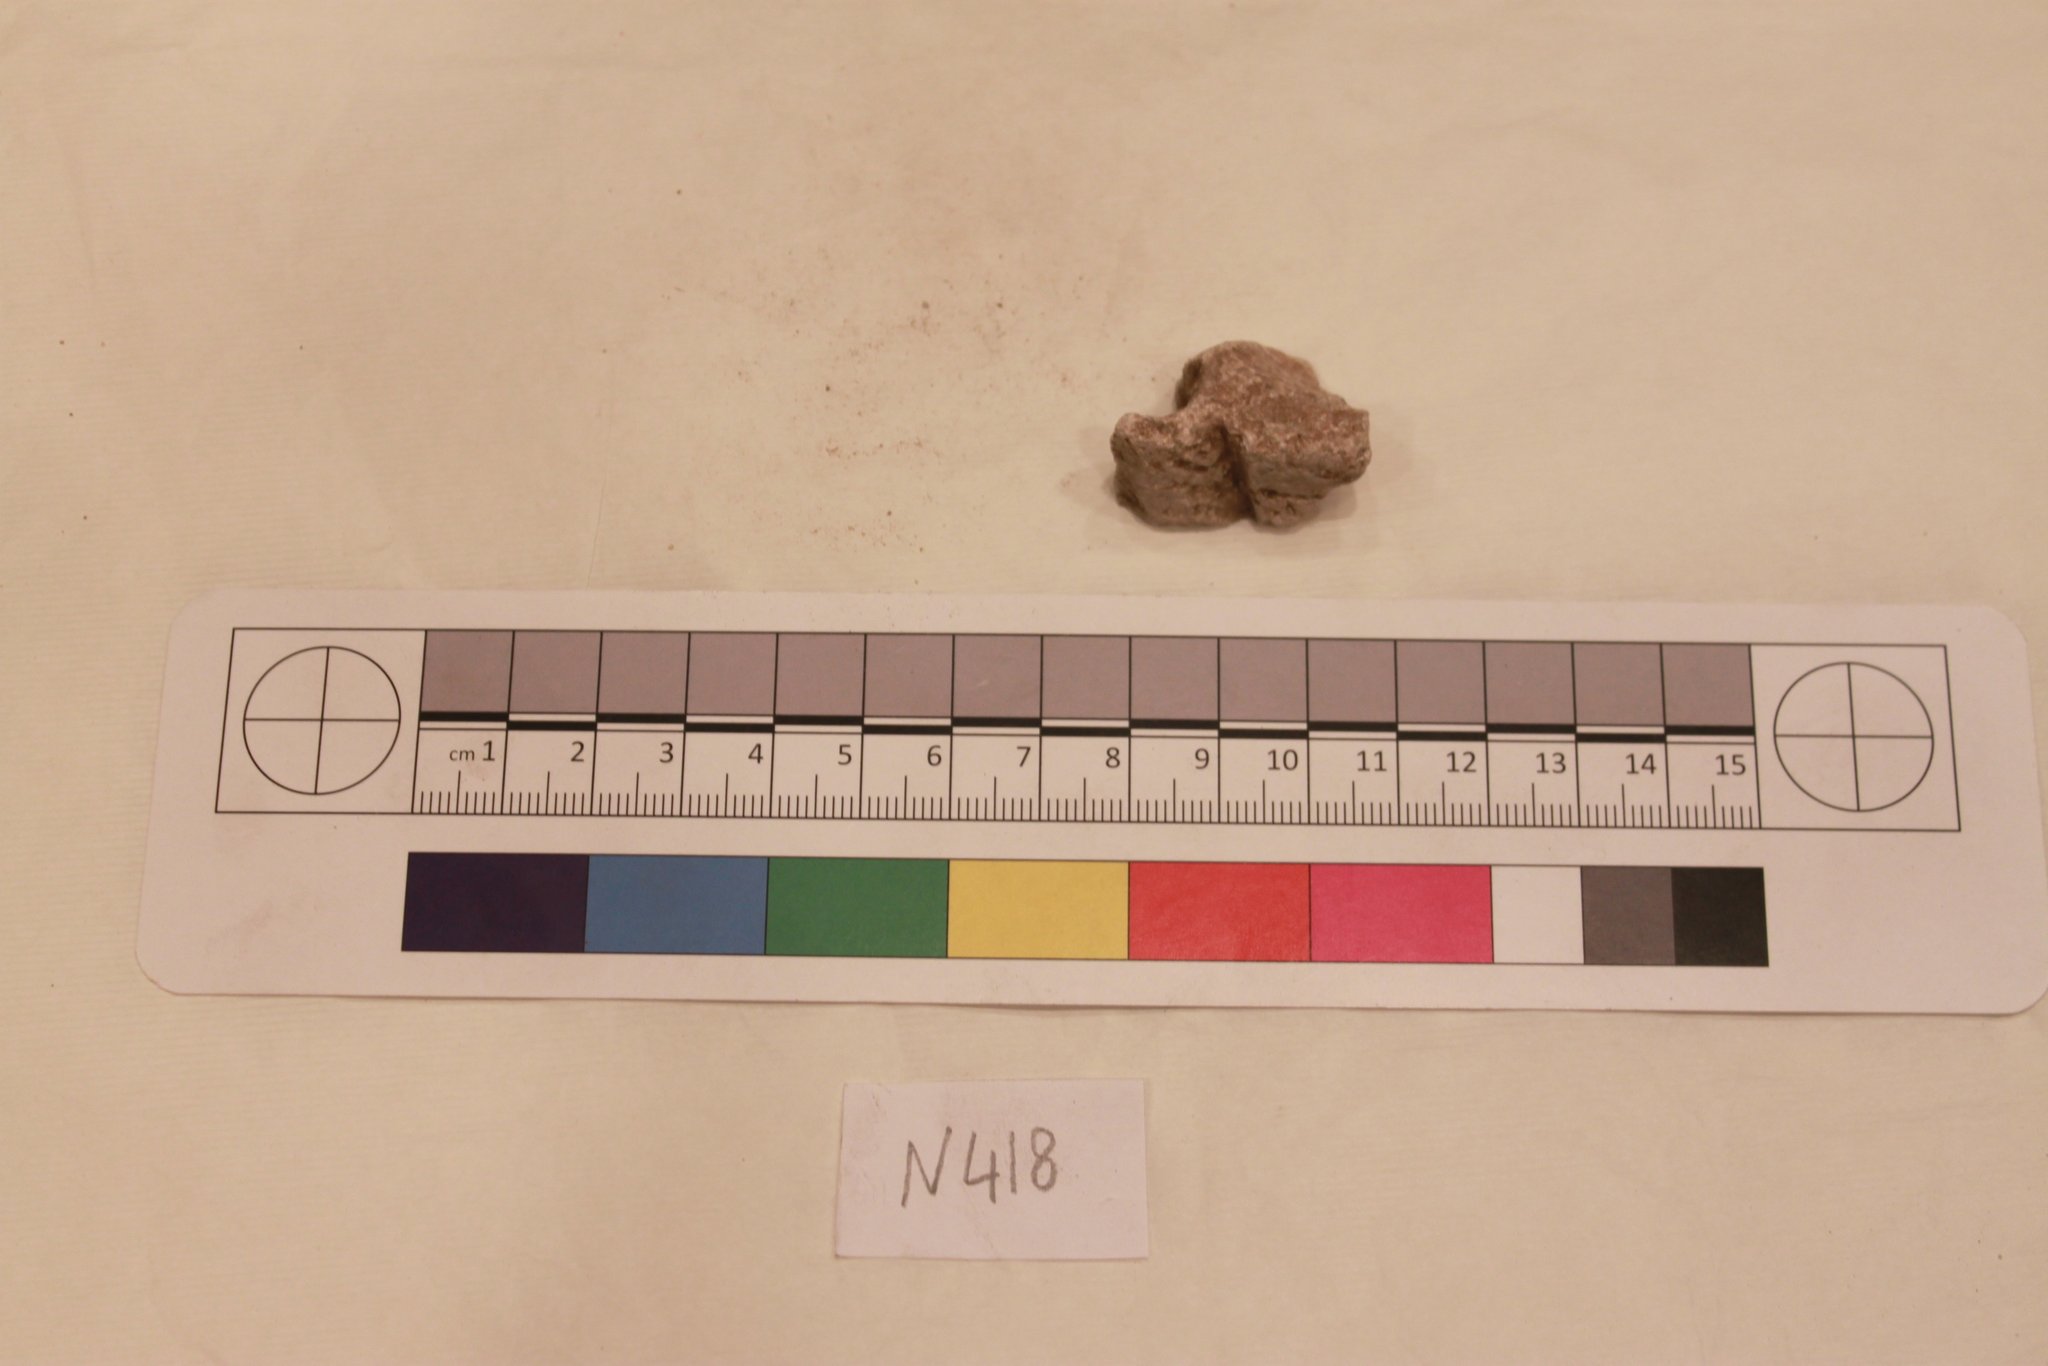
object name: fragment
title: Stucco Fragment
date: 701-1200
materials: plaster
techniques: carving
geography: iran